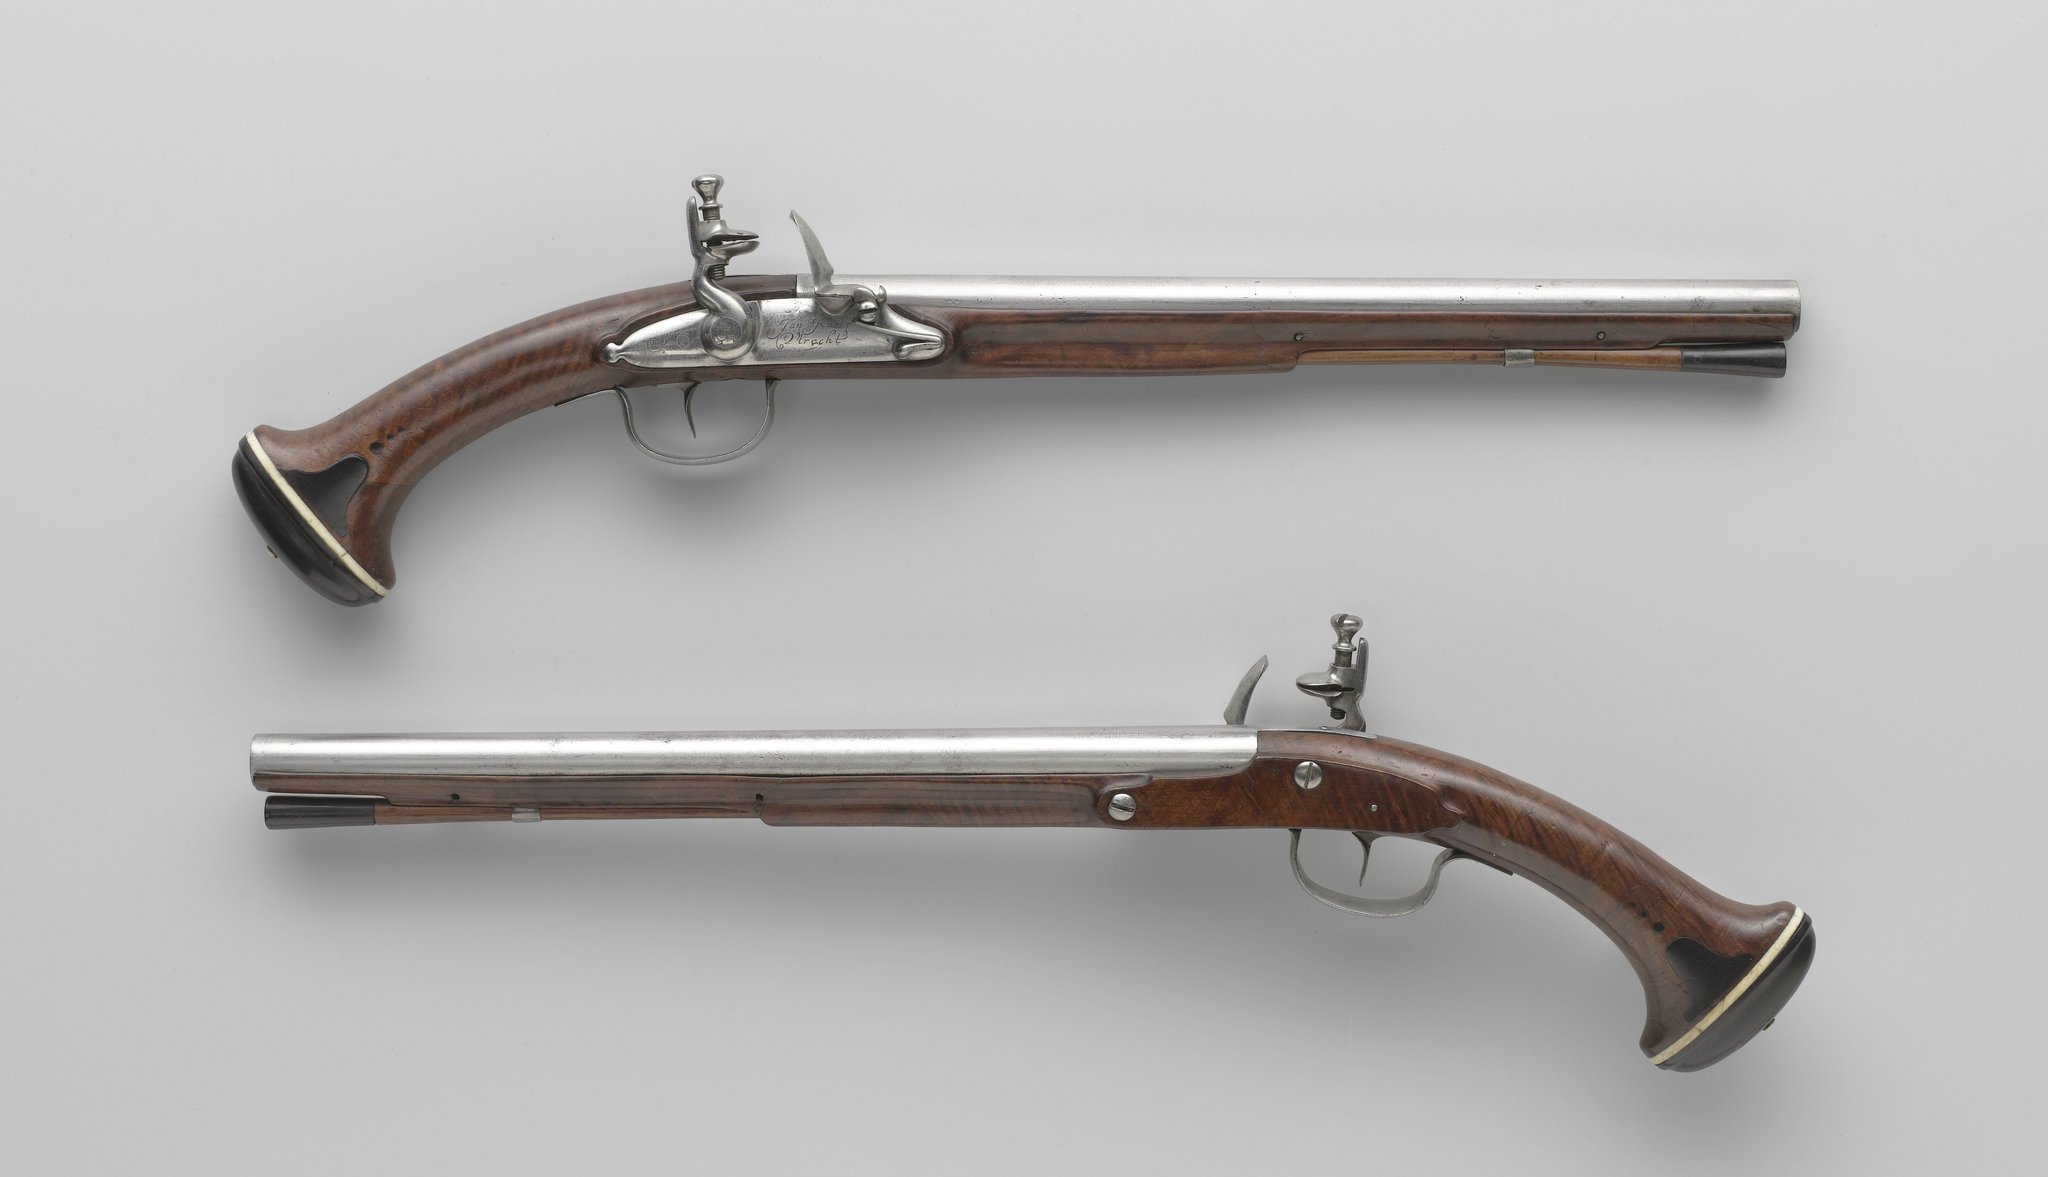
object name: flintlock pistol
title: Vuursteenpistool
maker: jan knoop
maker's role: geweermaker, lademaker, pistoolmaker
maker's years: 1610-1688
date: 1665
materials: wood, iron, ivory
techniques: printing, cutting, engraving, inlay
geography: utrecht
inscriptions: signature: ‘Jan Knoop // tVtrecht’, mark